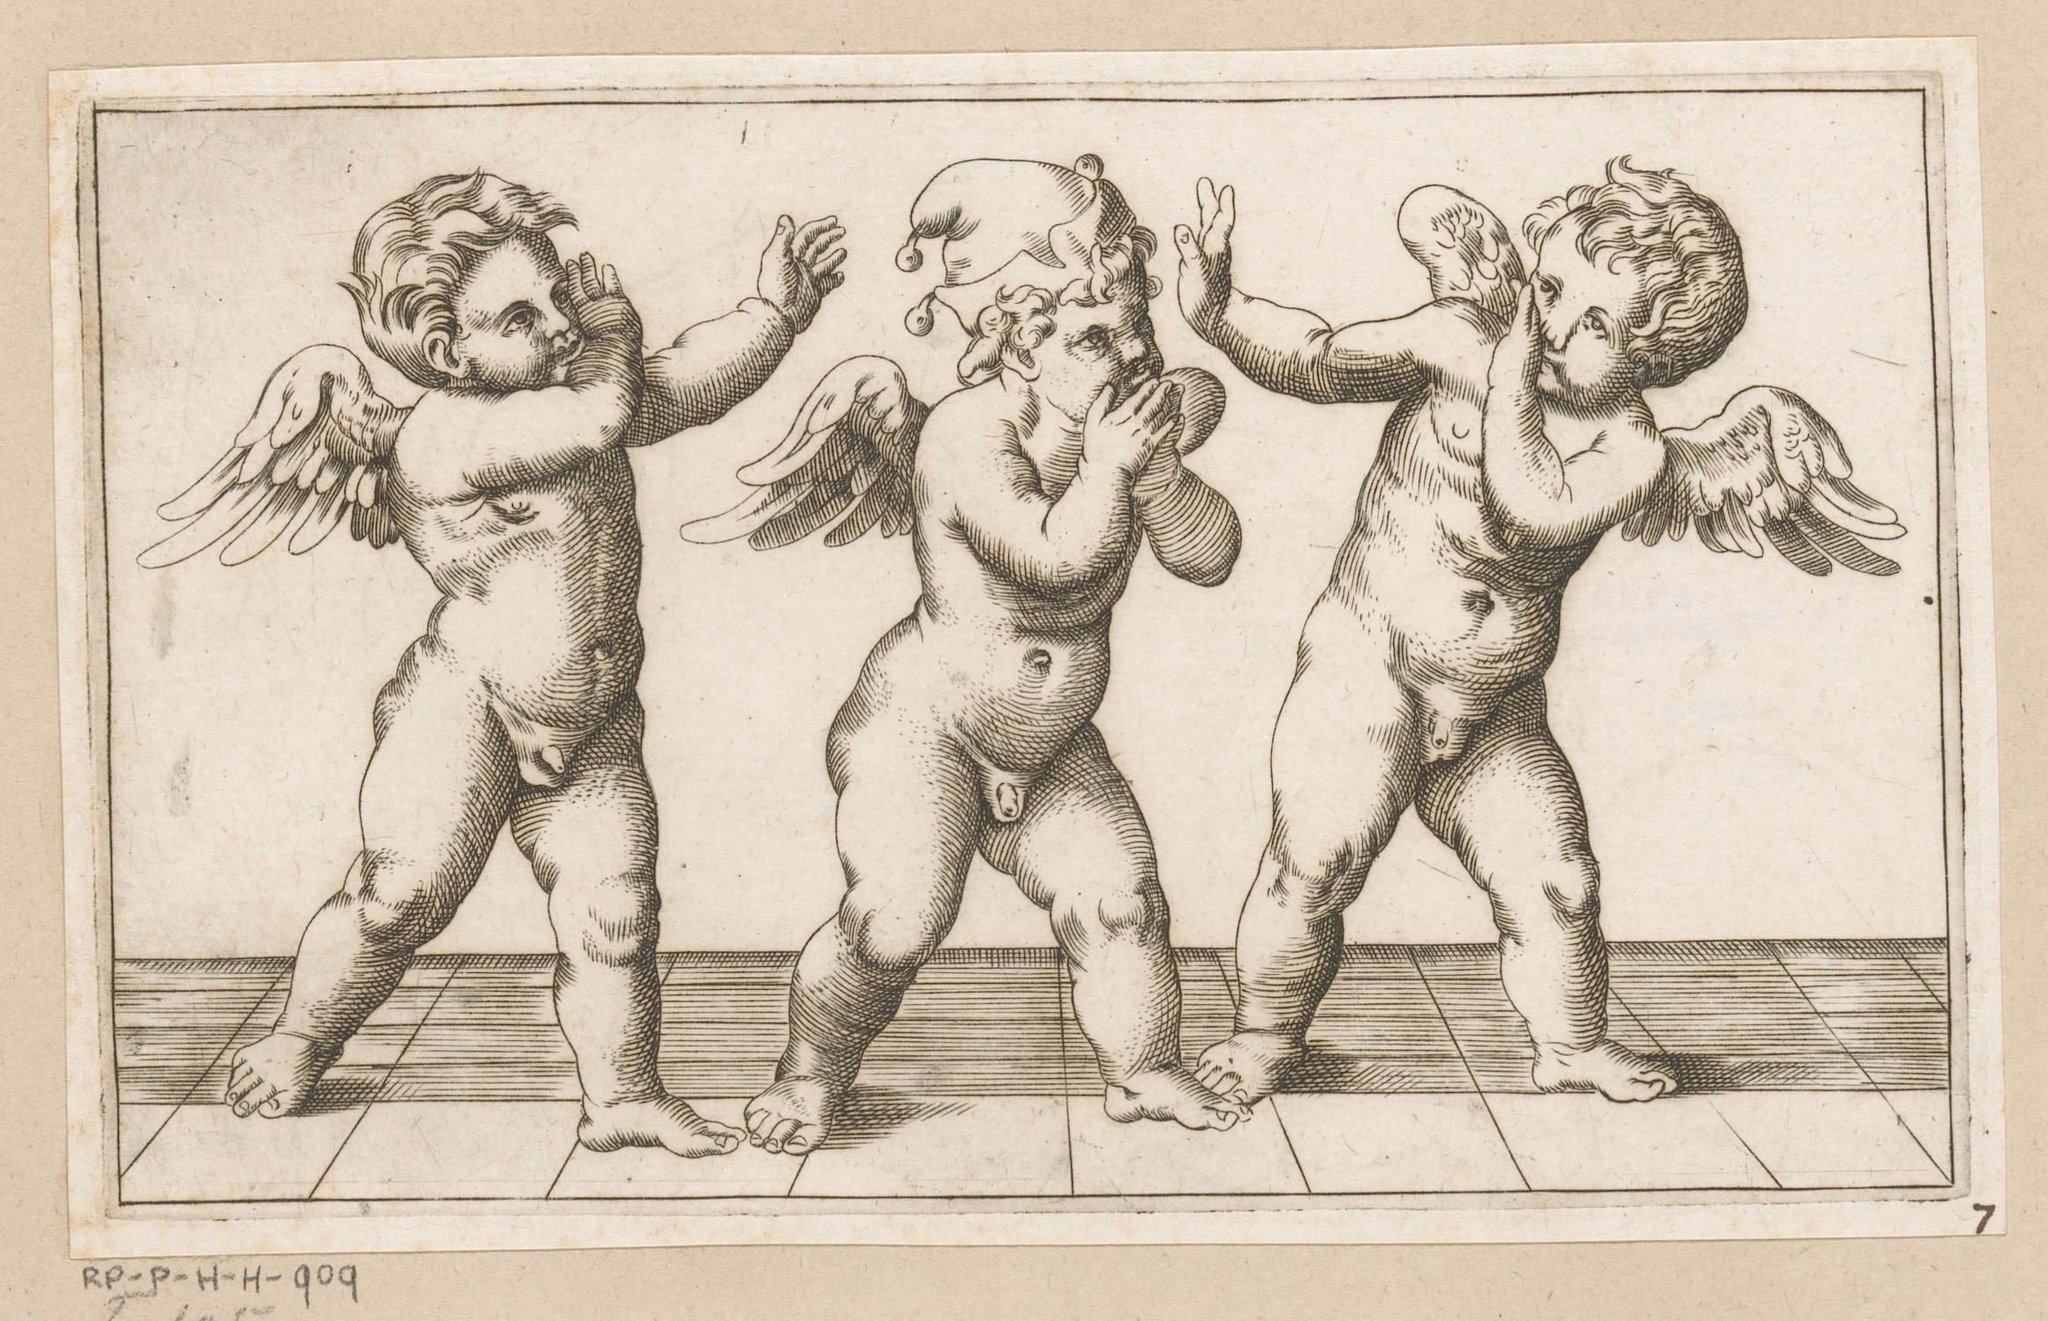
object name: print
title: Drie putti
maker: Anonymous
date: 1500-1599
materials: paper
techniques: engraving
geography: italy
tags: fool's cap, cupids: 'amores', 'amoretti', 'putti'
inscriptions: collector's mark: ‘Hinloopen’, collector's mark: Lugt 11, collector's mark: Lugt 10, number: ‘7’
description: Drie staande putti op een rij. De middelste putto heeft een zotskap op het hoofd.